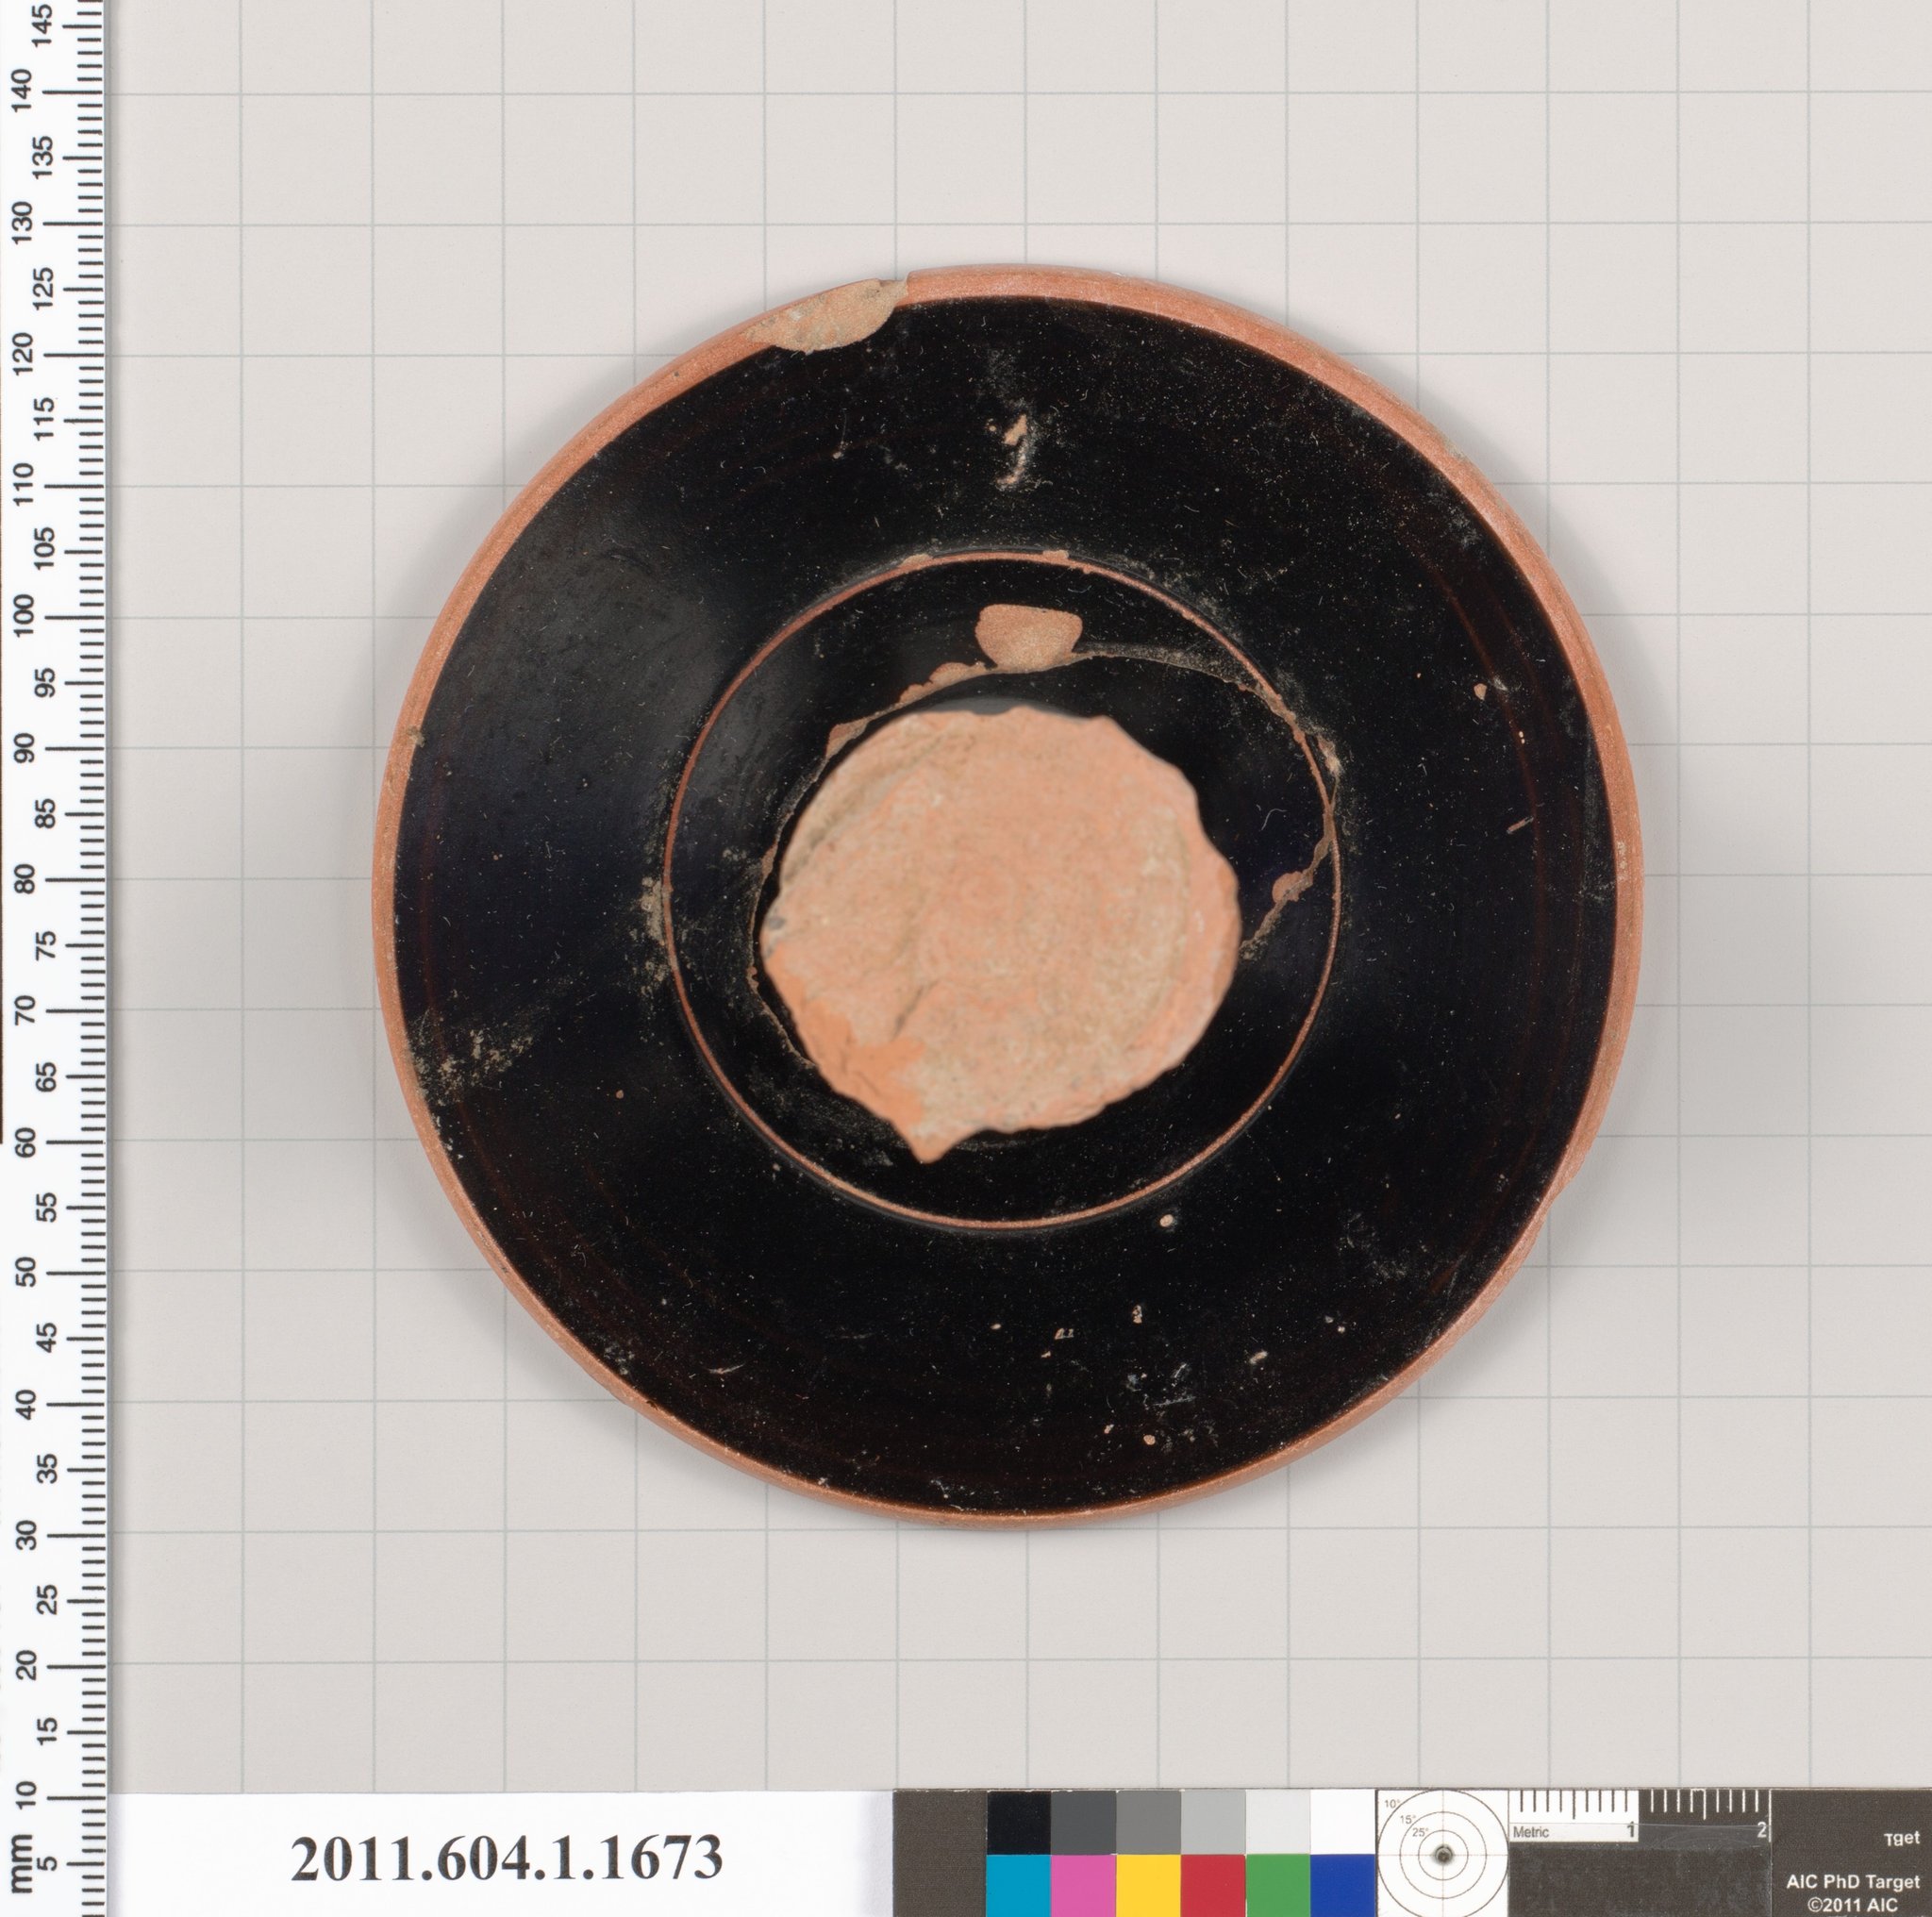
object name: kylix fragment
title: Terracotta fragment of a kylix (drinking cup)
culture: greek, attic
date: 534-468 BCE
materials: terracotta